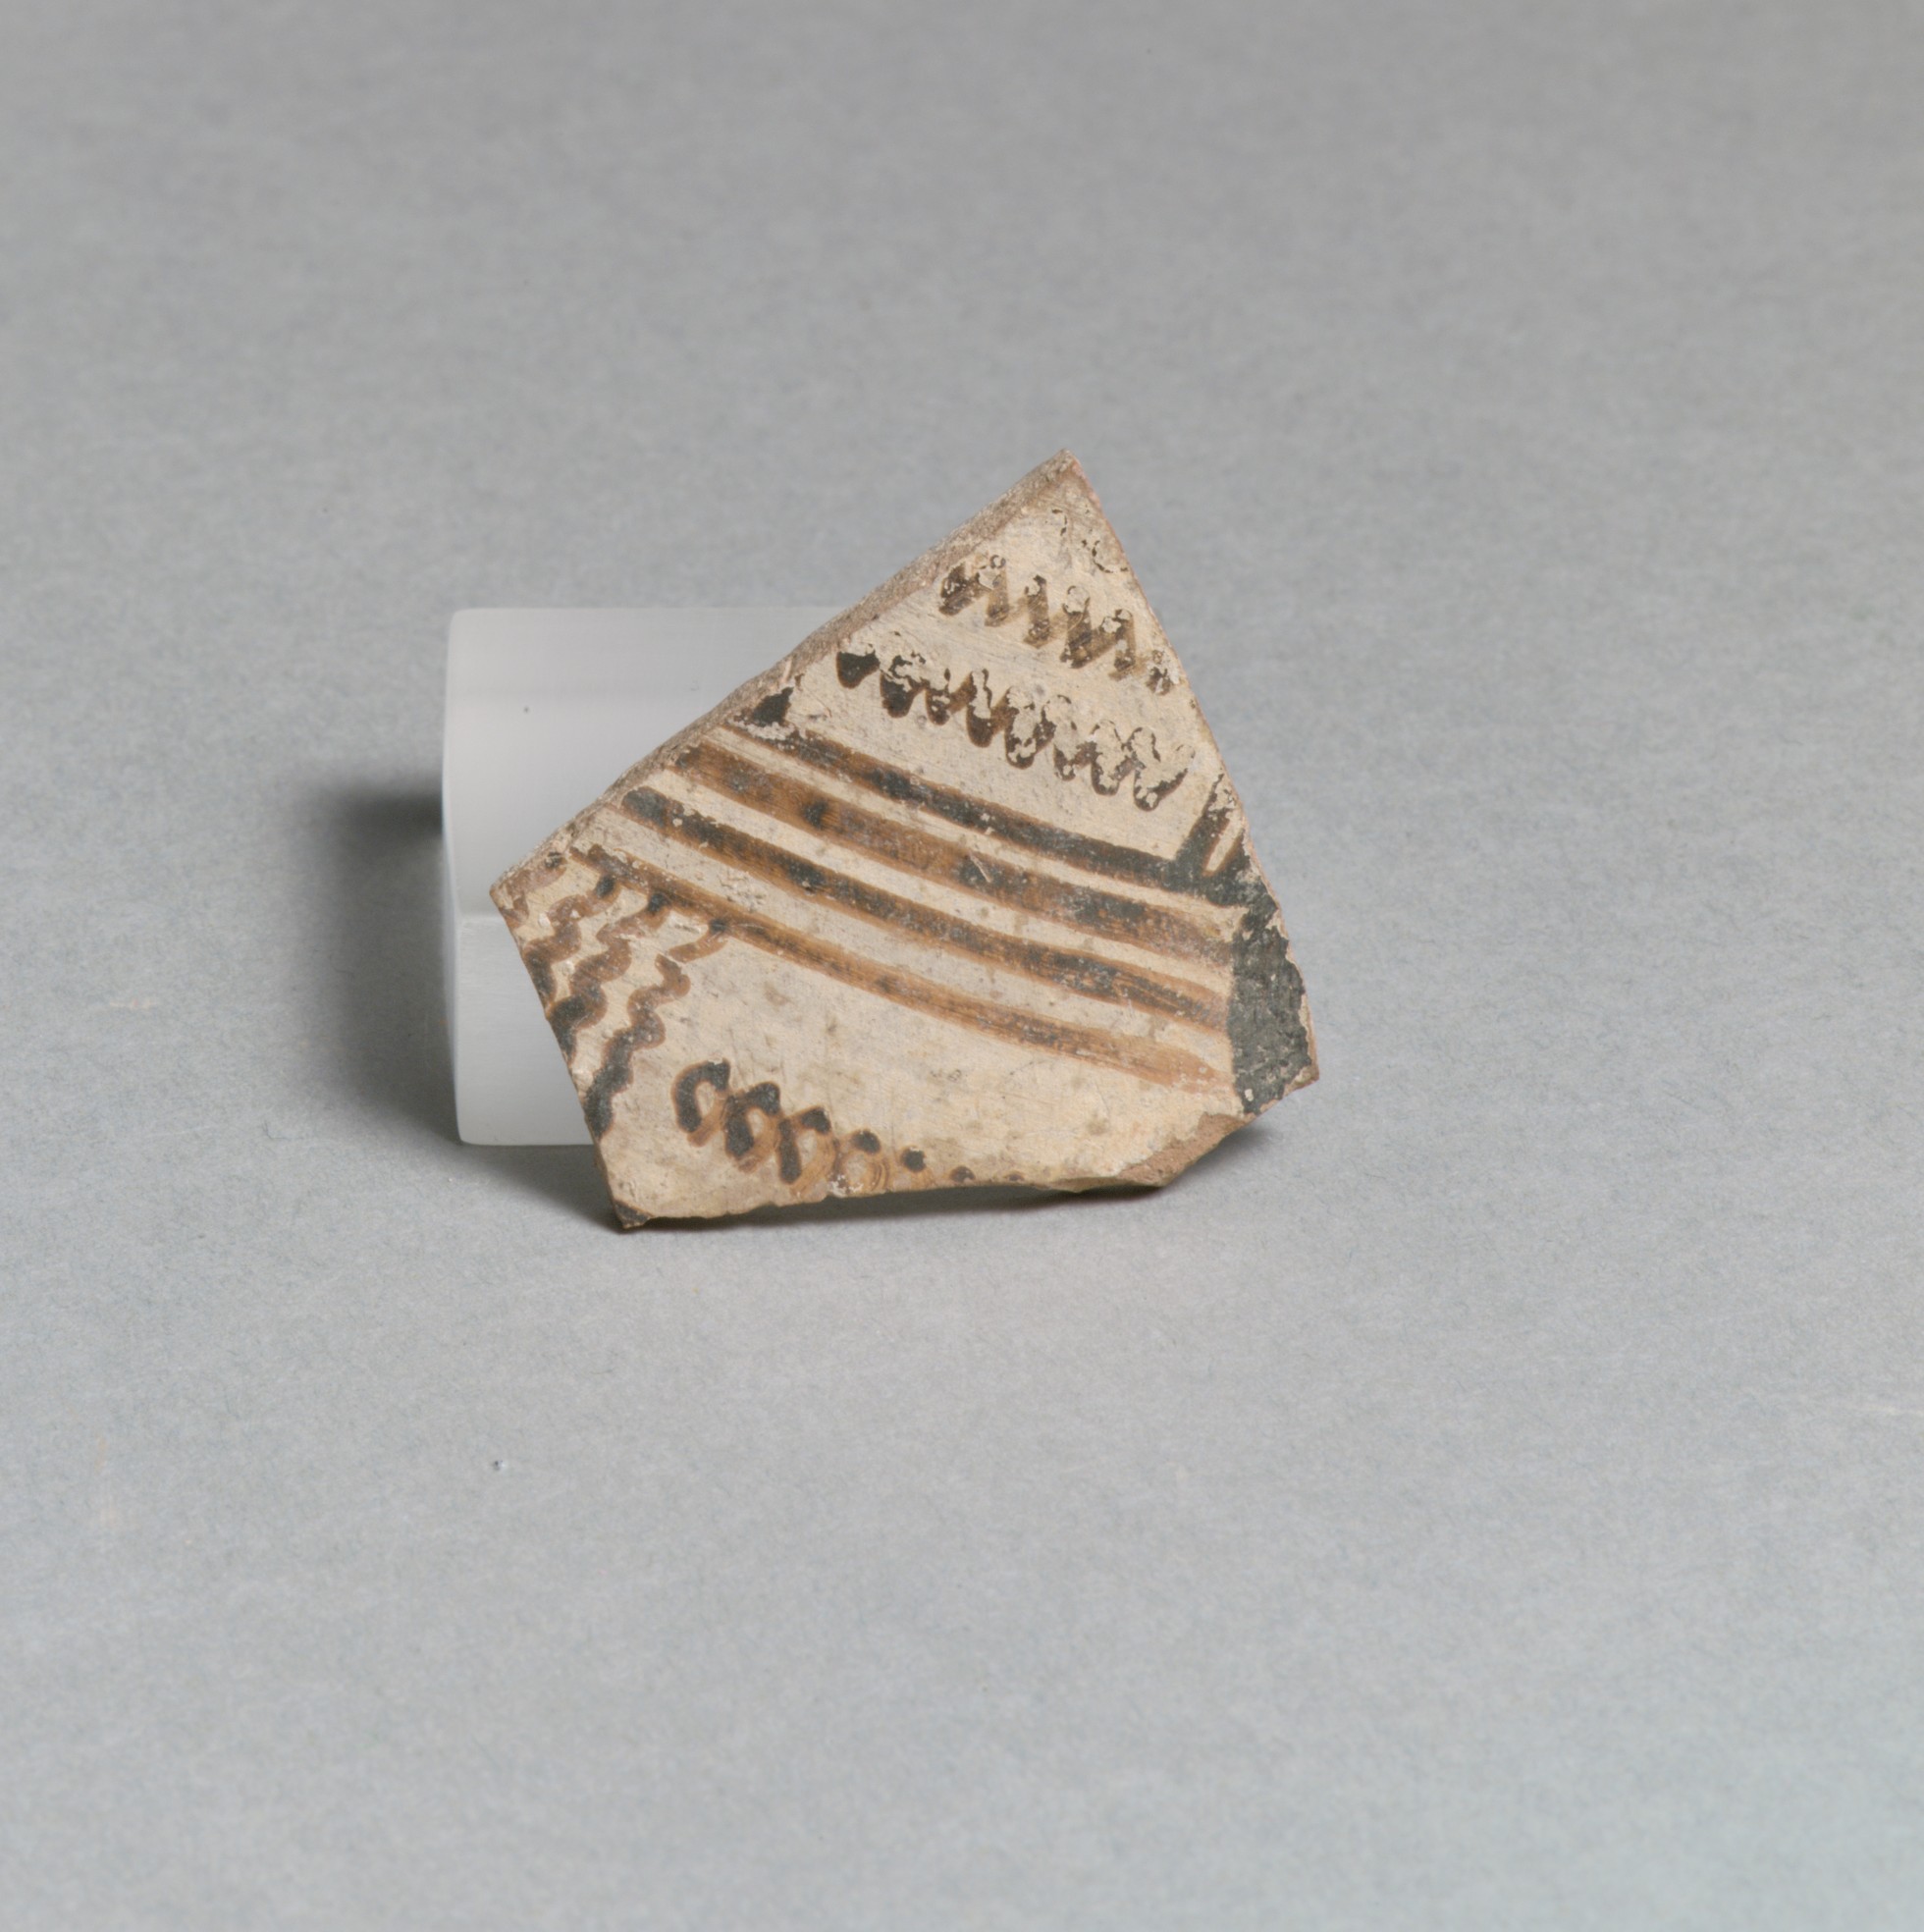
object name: vase fragment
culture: greek, laconian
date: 2000-1550 BCE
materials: terracotta